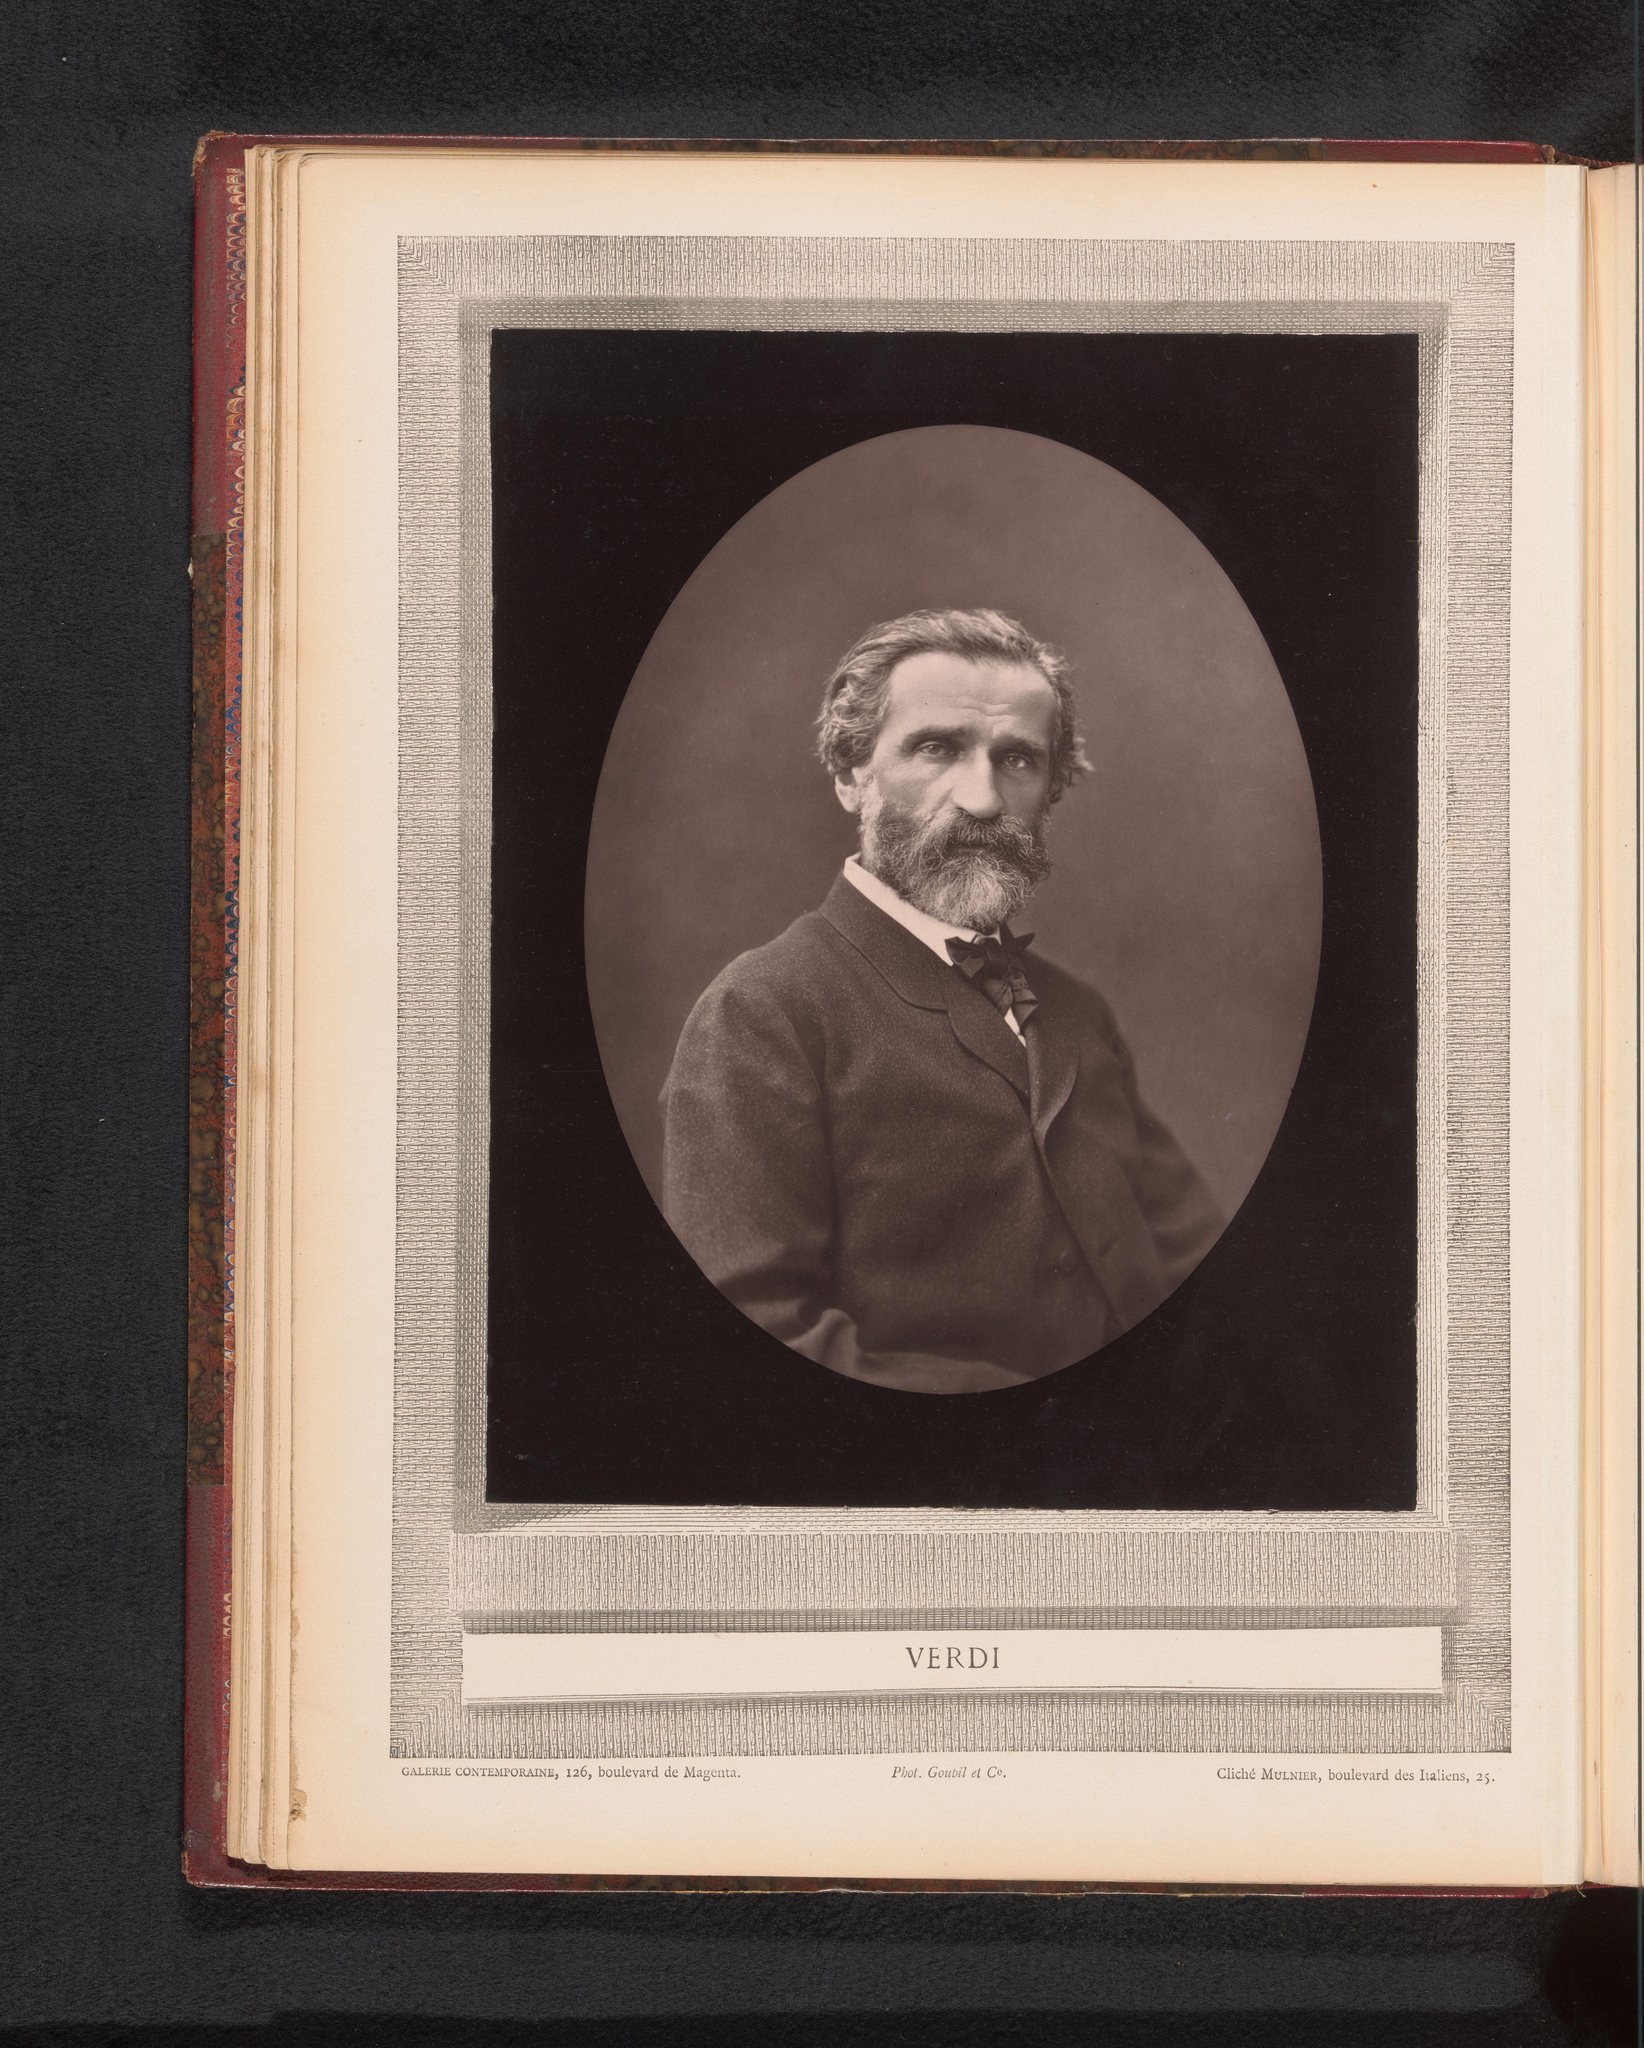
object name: page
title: Portret van Giuseppe Verdi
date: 1872-1877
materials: paper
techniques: woodburytype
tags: italy, adult man, historical persons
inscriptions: inscription: ‘Galerie Contemporaine, 126, boulevard de Magenta.’